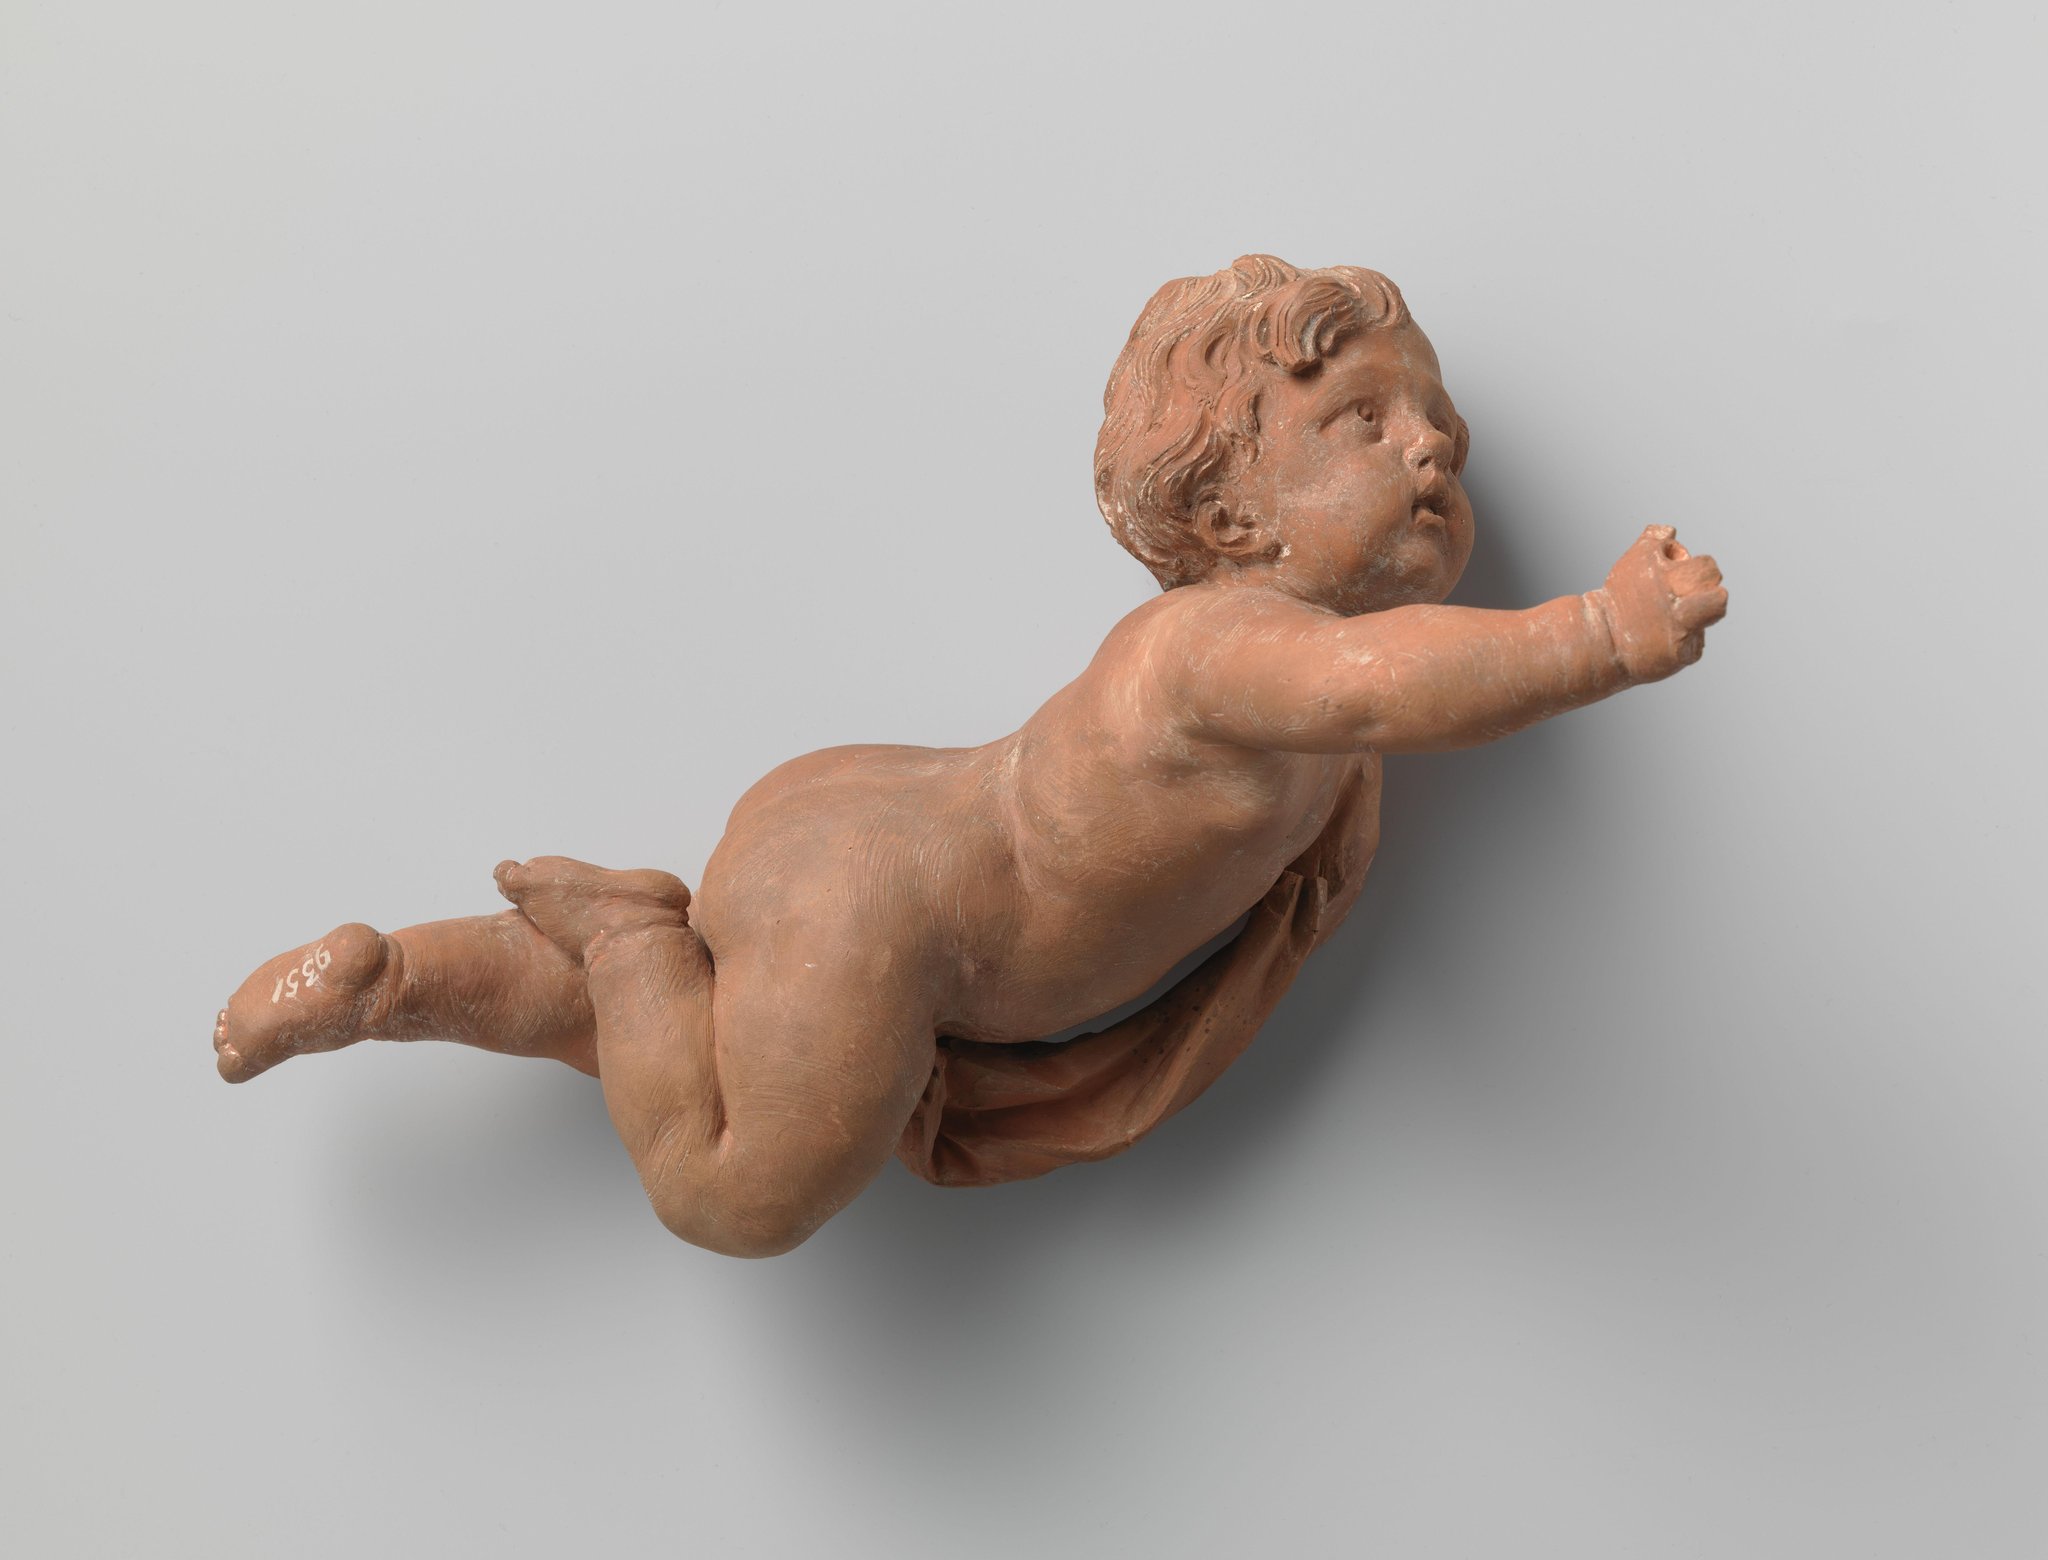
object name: sculpture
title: Study for a Hovering Putto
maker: laurent delvaux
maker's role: sculptor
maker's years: 1696-1778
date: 1735-1750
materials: terracotta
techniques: modeling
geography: southern netherlands